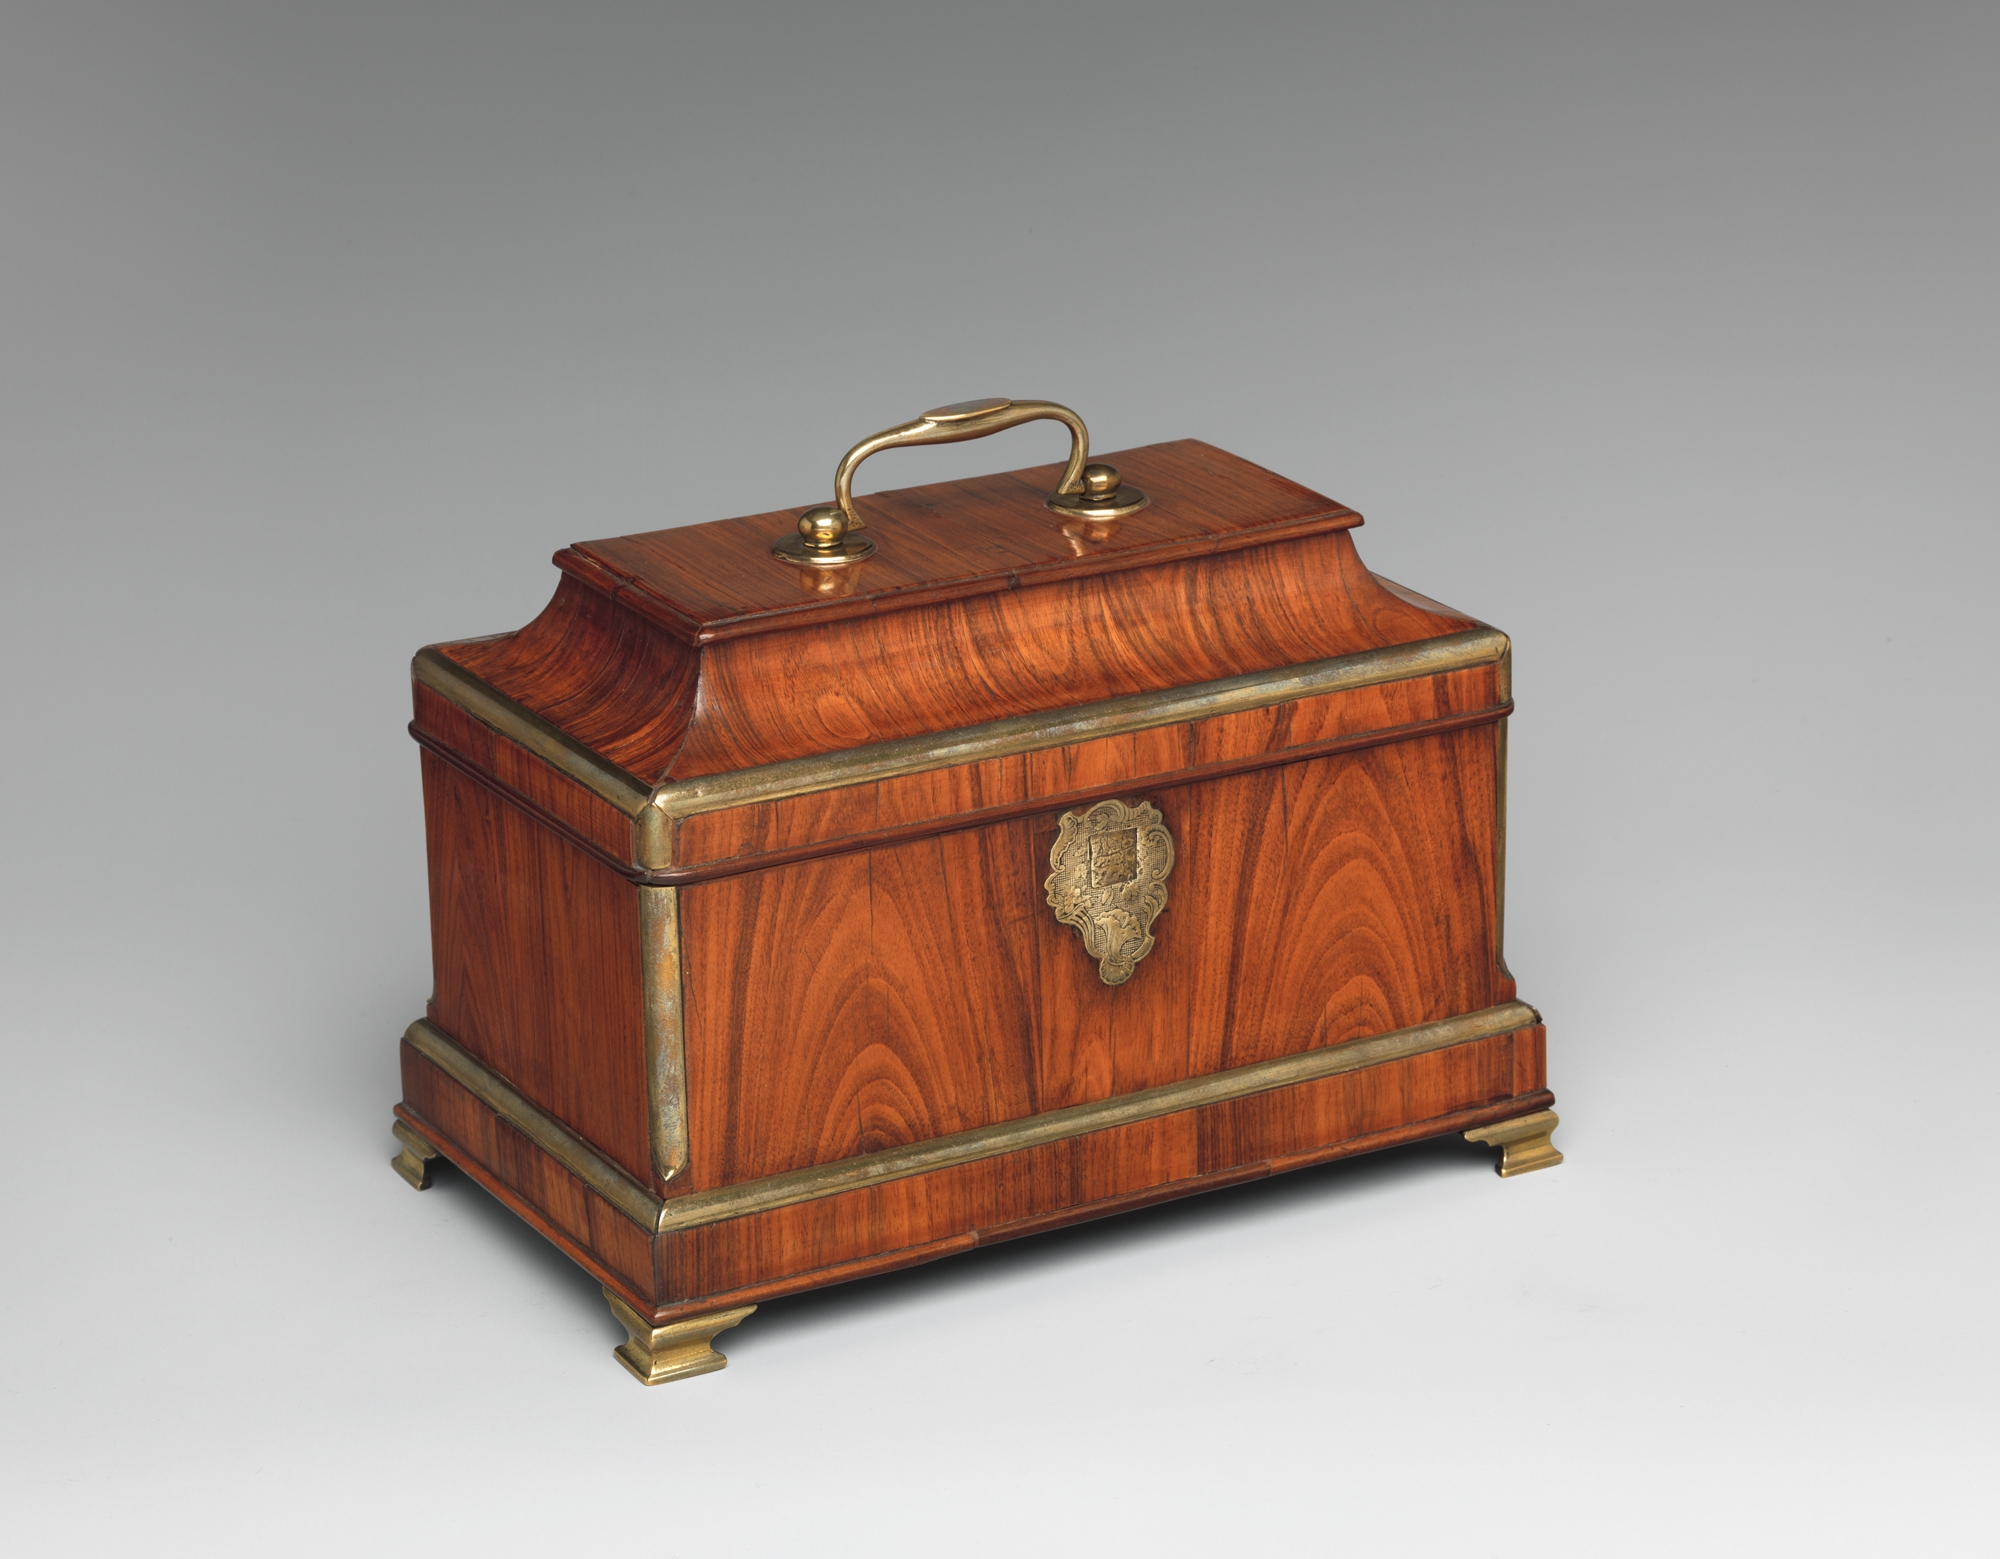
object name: tea chest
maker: abraham roentgen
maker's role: maker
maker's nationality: german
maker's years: 1711-1793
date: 1750-1755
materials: brass, wood, iron, steel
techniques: veneering